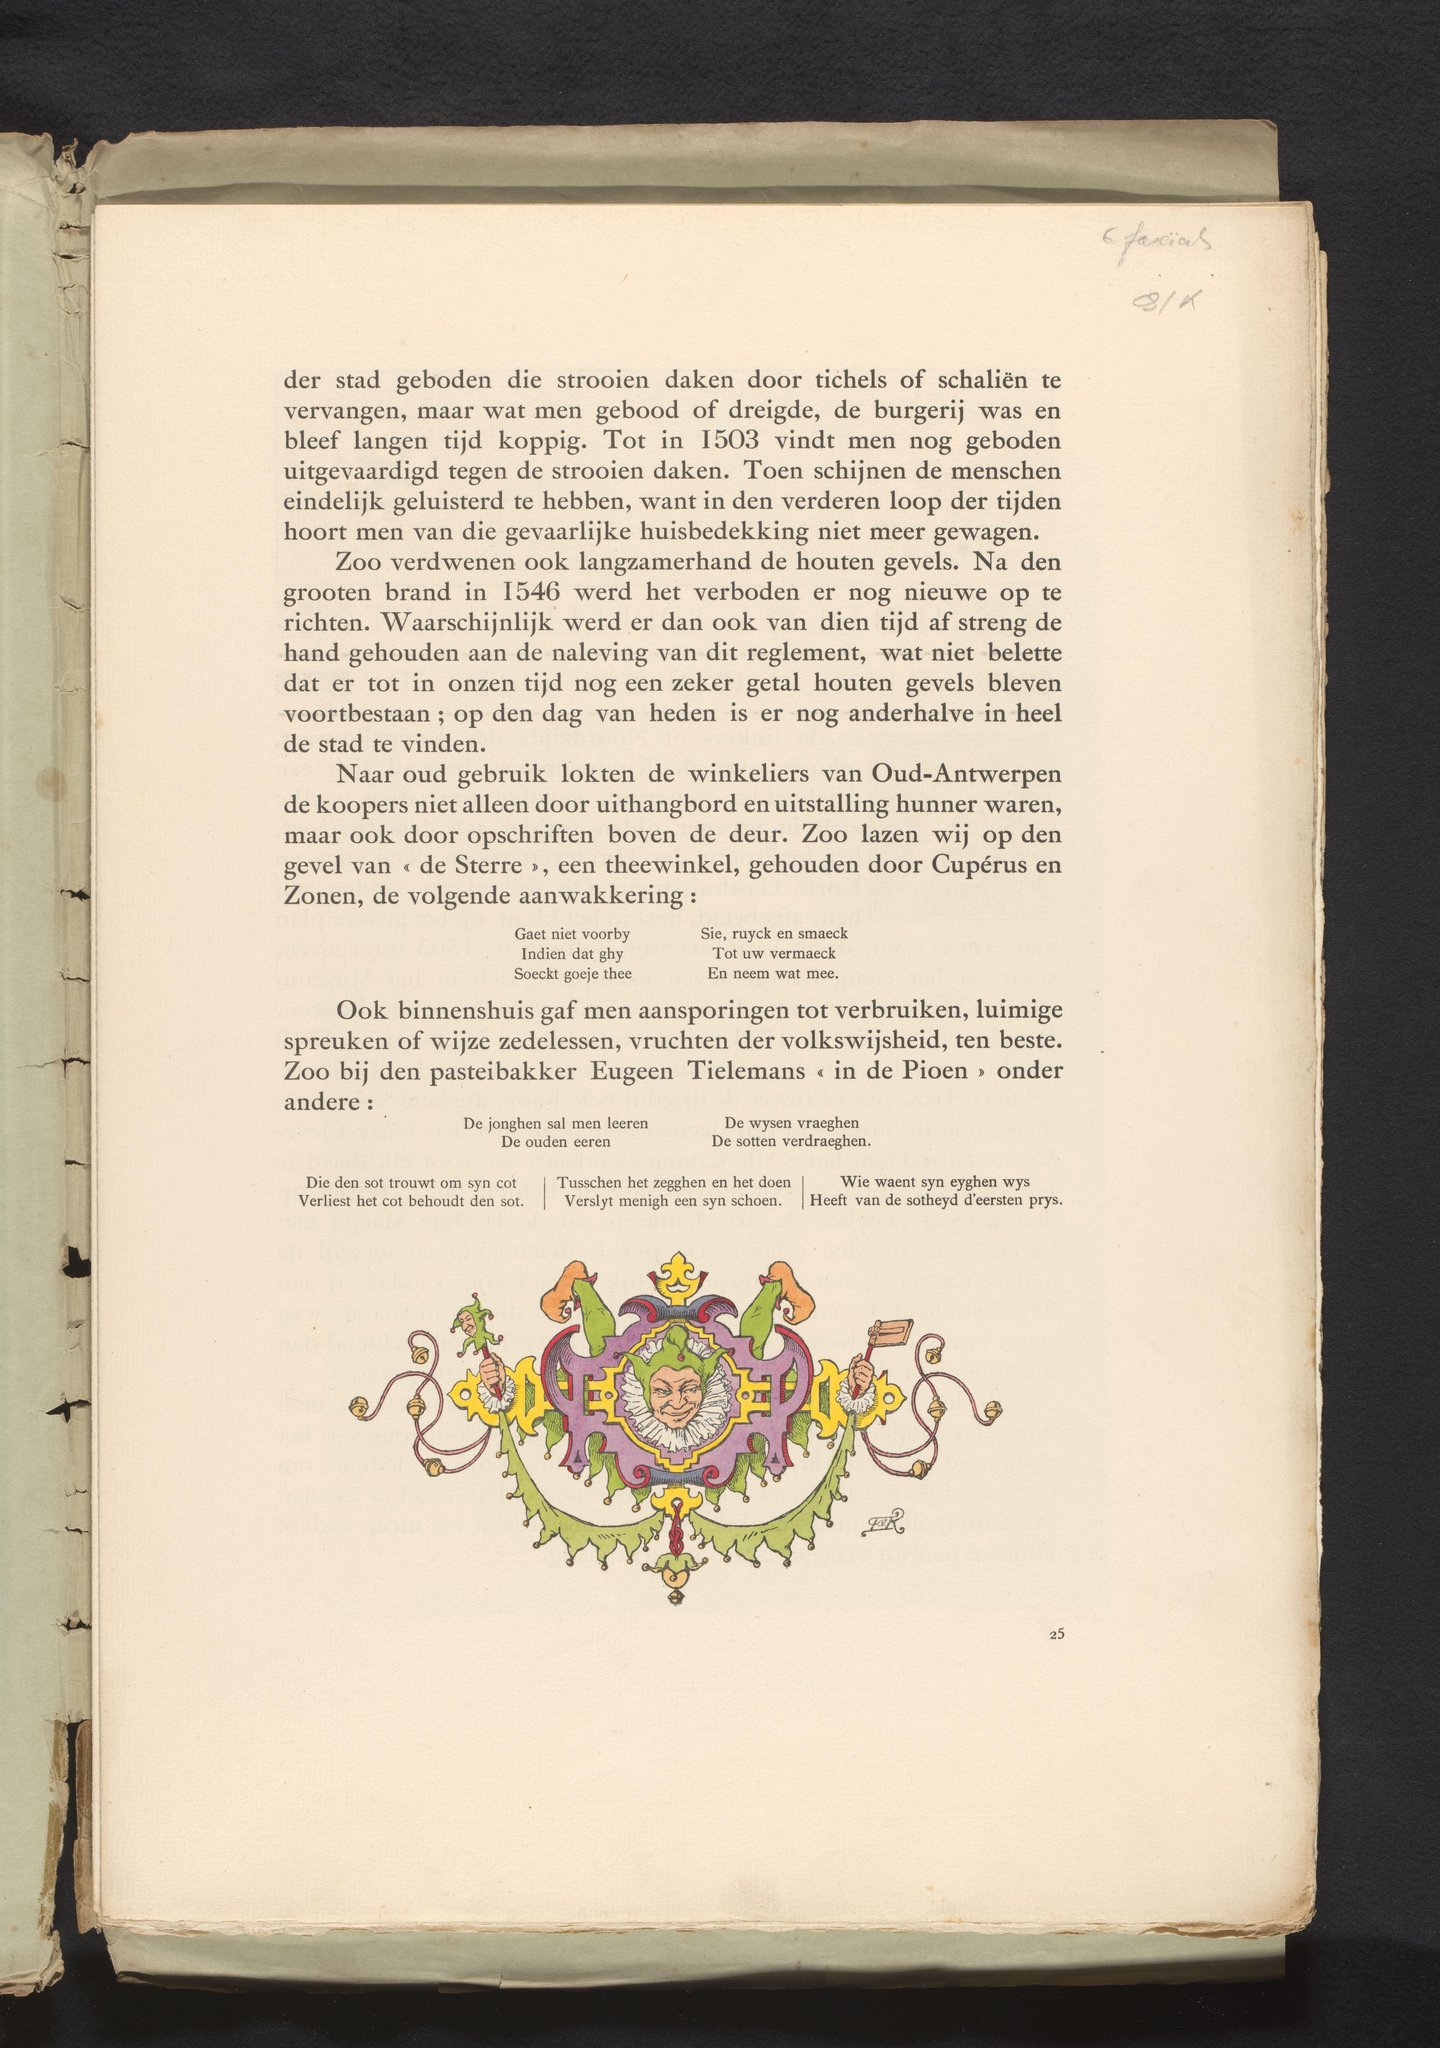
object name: book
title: De wijk Oud-Antwerpen in de wereldtentoonstelling van 1894 / in beeld gebracht door Frans van Kuyck; beschreven door Max Rooses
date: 1894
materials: paper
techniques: photograph, lithograph, printing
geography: brussels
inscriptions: annotation: ‘6 fa[...]ls/ cs/k’